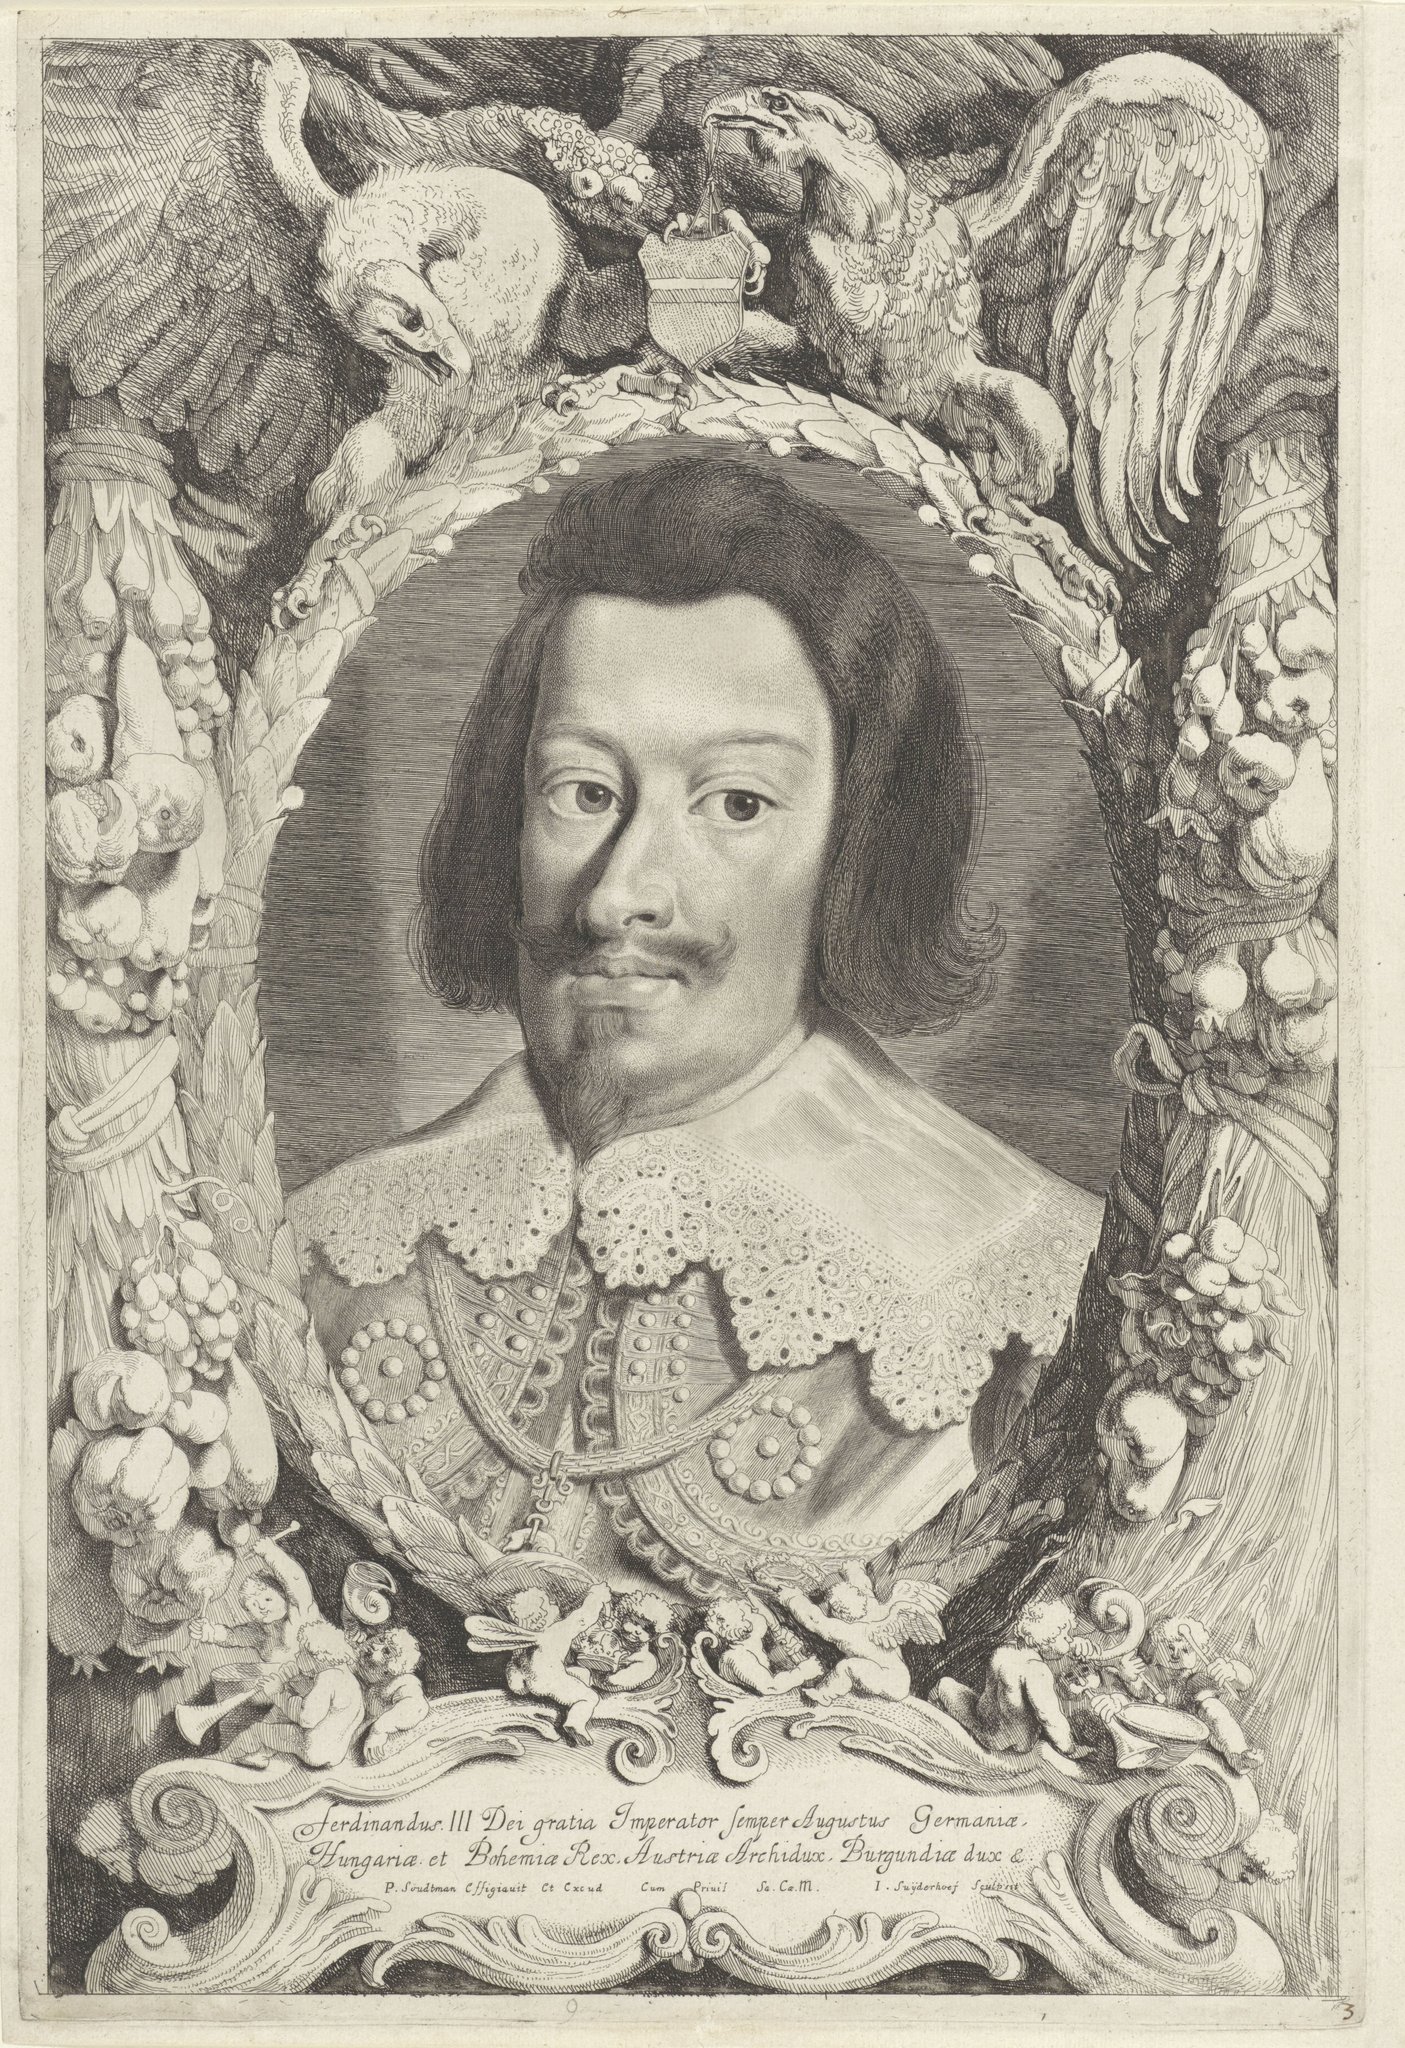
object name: print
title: Portret van keizer Ferdinand III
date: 1644-1650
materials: paper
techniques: engraving, etching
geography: haarlem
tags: vienna, ferdinand iii (duits keizer), knighthood order of the golden fleece - insignia of a knighthood order, e.g.: badge, chain (with name of order), ornament ~ festoon, garland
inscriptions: collector's mark: Lugt 2760, collector's mark: Lugt 2228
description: Portret van Ferdinand III, Duits keizer, met het ordeteken van de Orde van het Gulden Vlies op zijn borst. Het portret is gevat in een ornamentele omlijsting met guirlandes van vruchten. Midden onder een cartouche met zijn naam en titel in het Latijn.